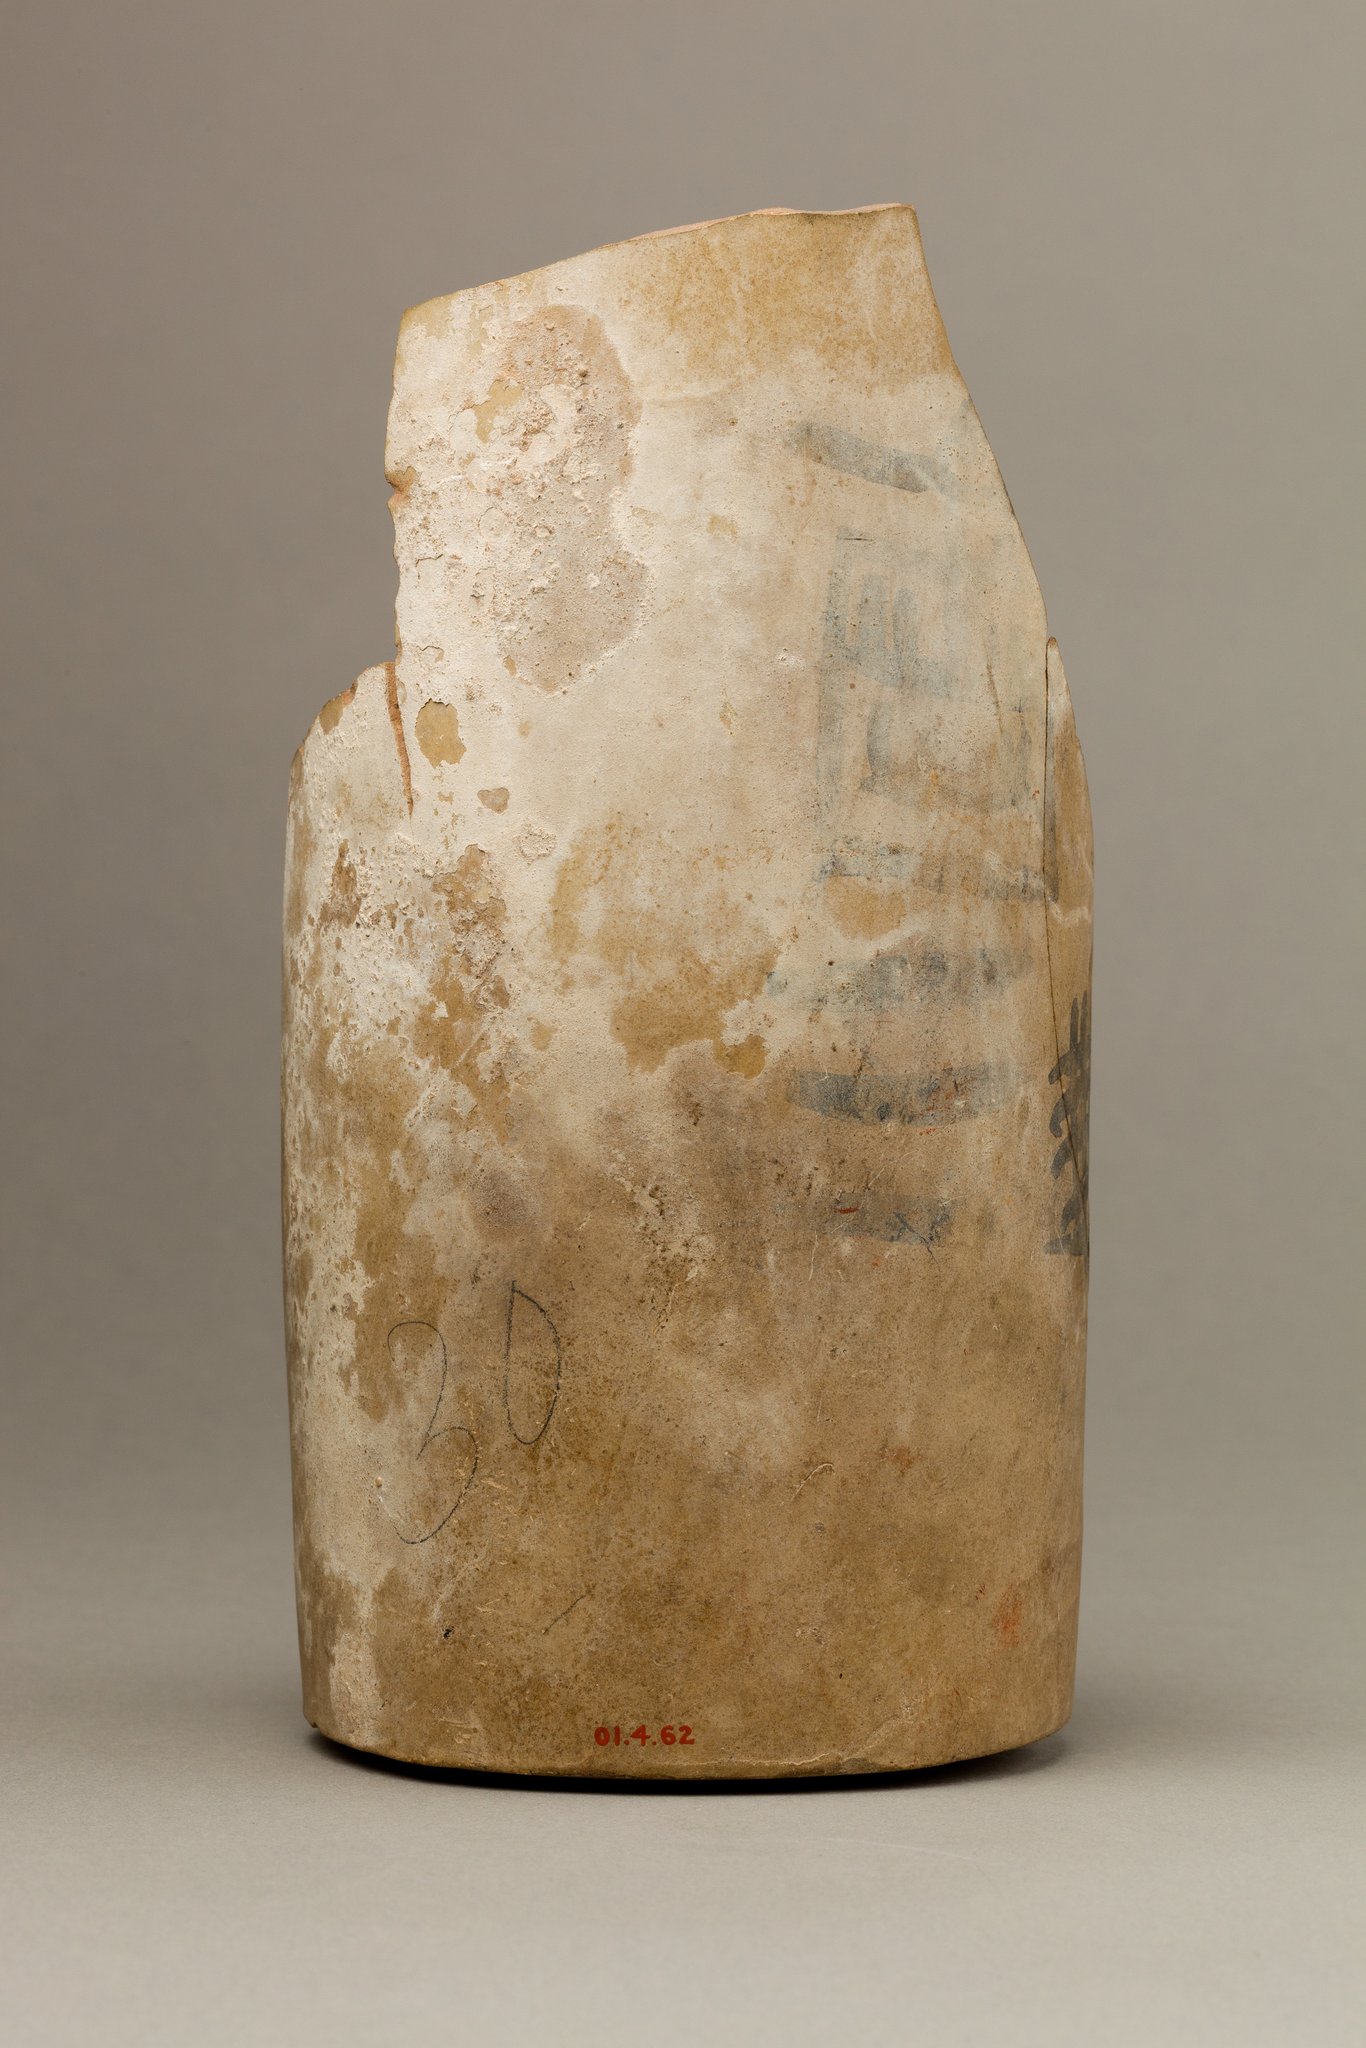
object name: vase, labeling a royal estate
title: Pottery vase with inscription labeling a royal estate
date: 3100 BCE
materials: ink, pottery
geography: egypt